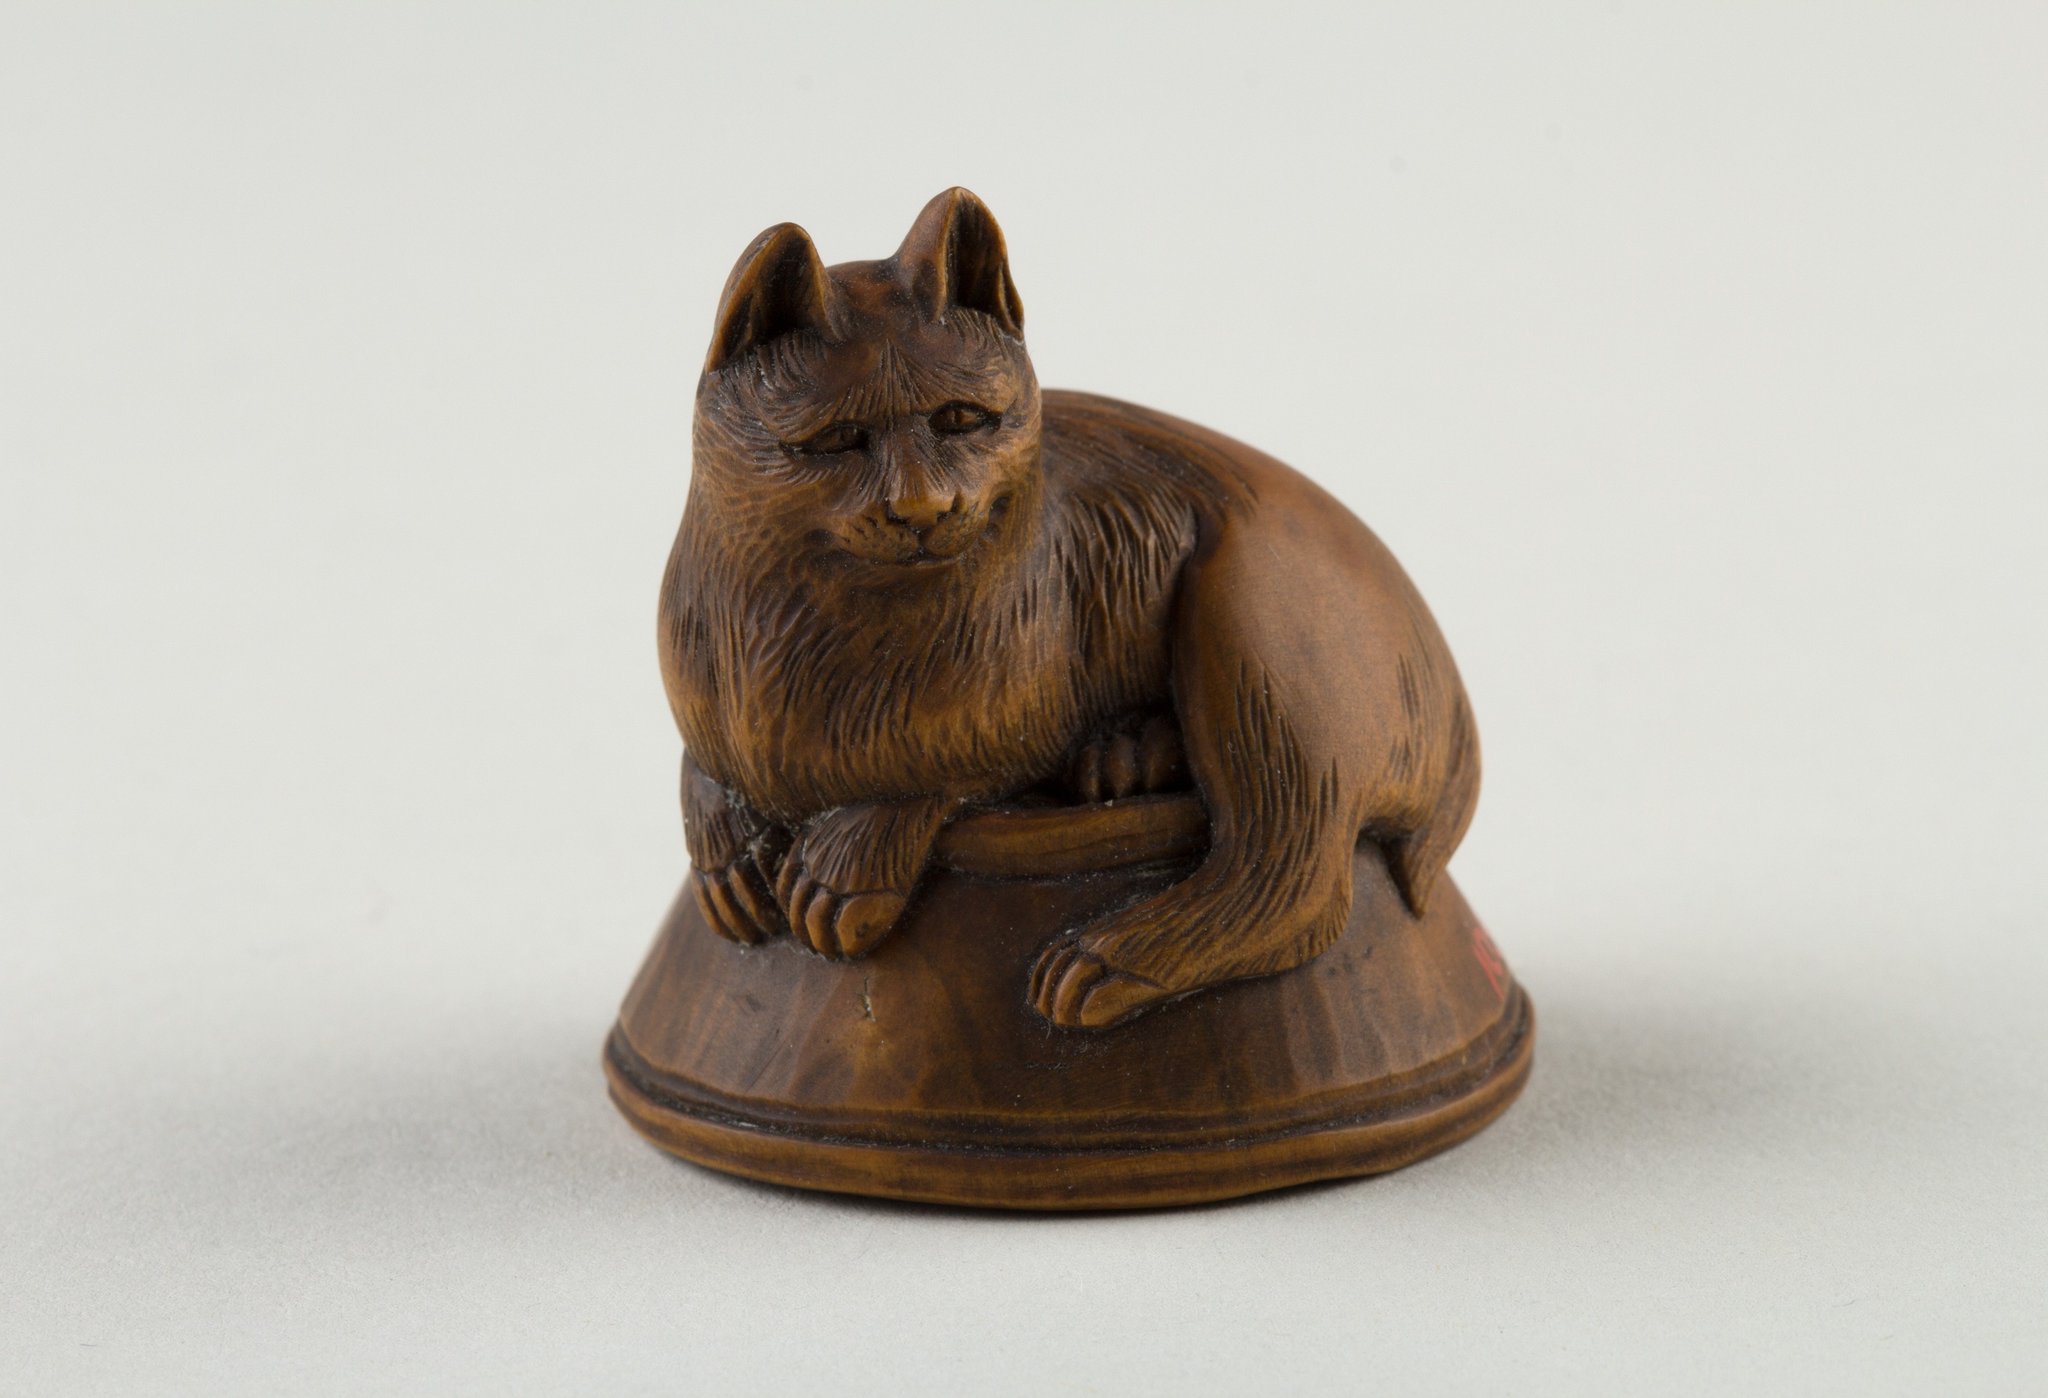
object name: netsuke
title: Netsuke of Cat Lying on a Bowl, underneath which is a Fish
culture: japanese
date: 1801-1900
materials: wood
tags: cats